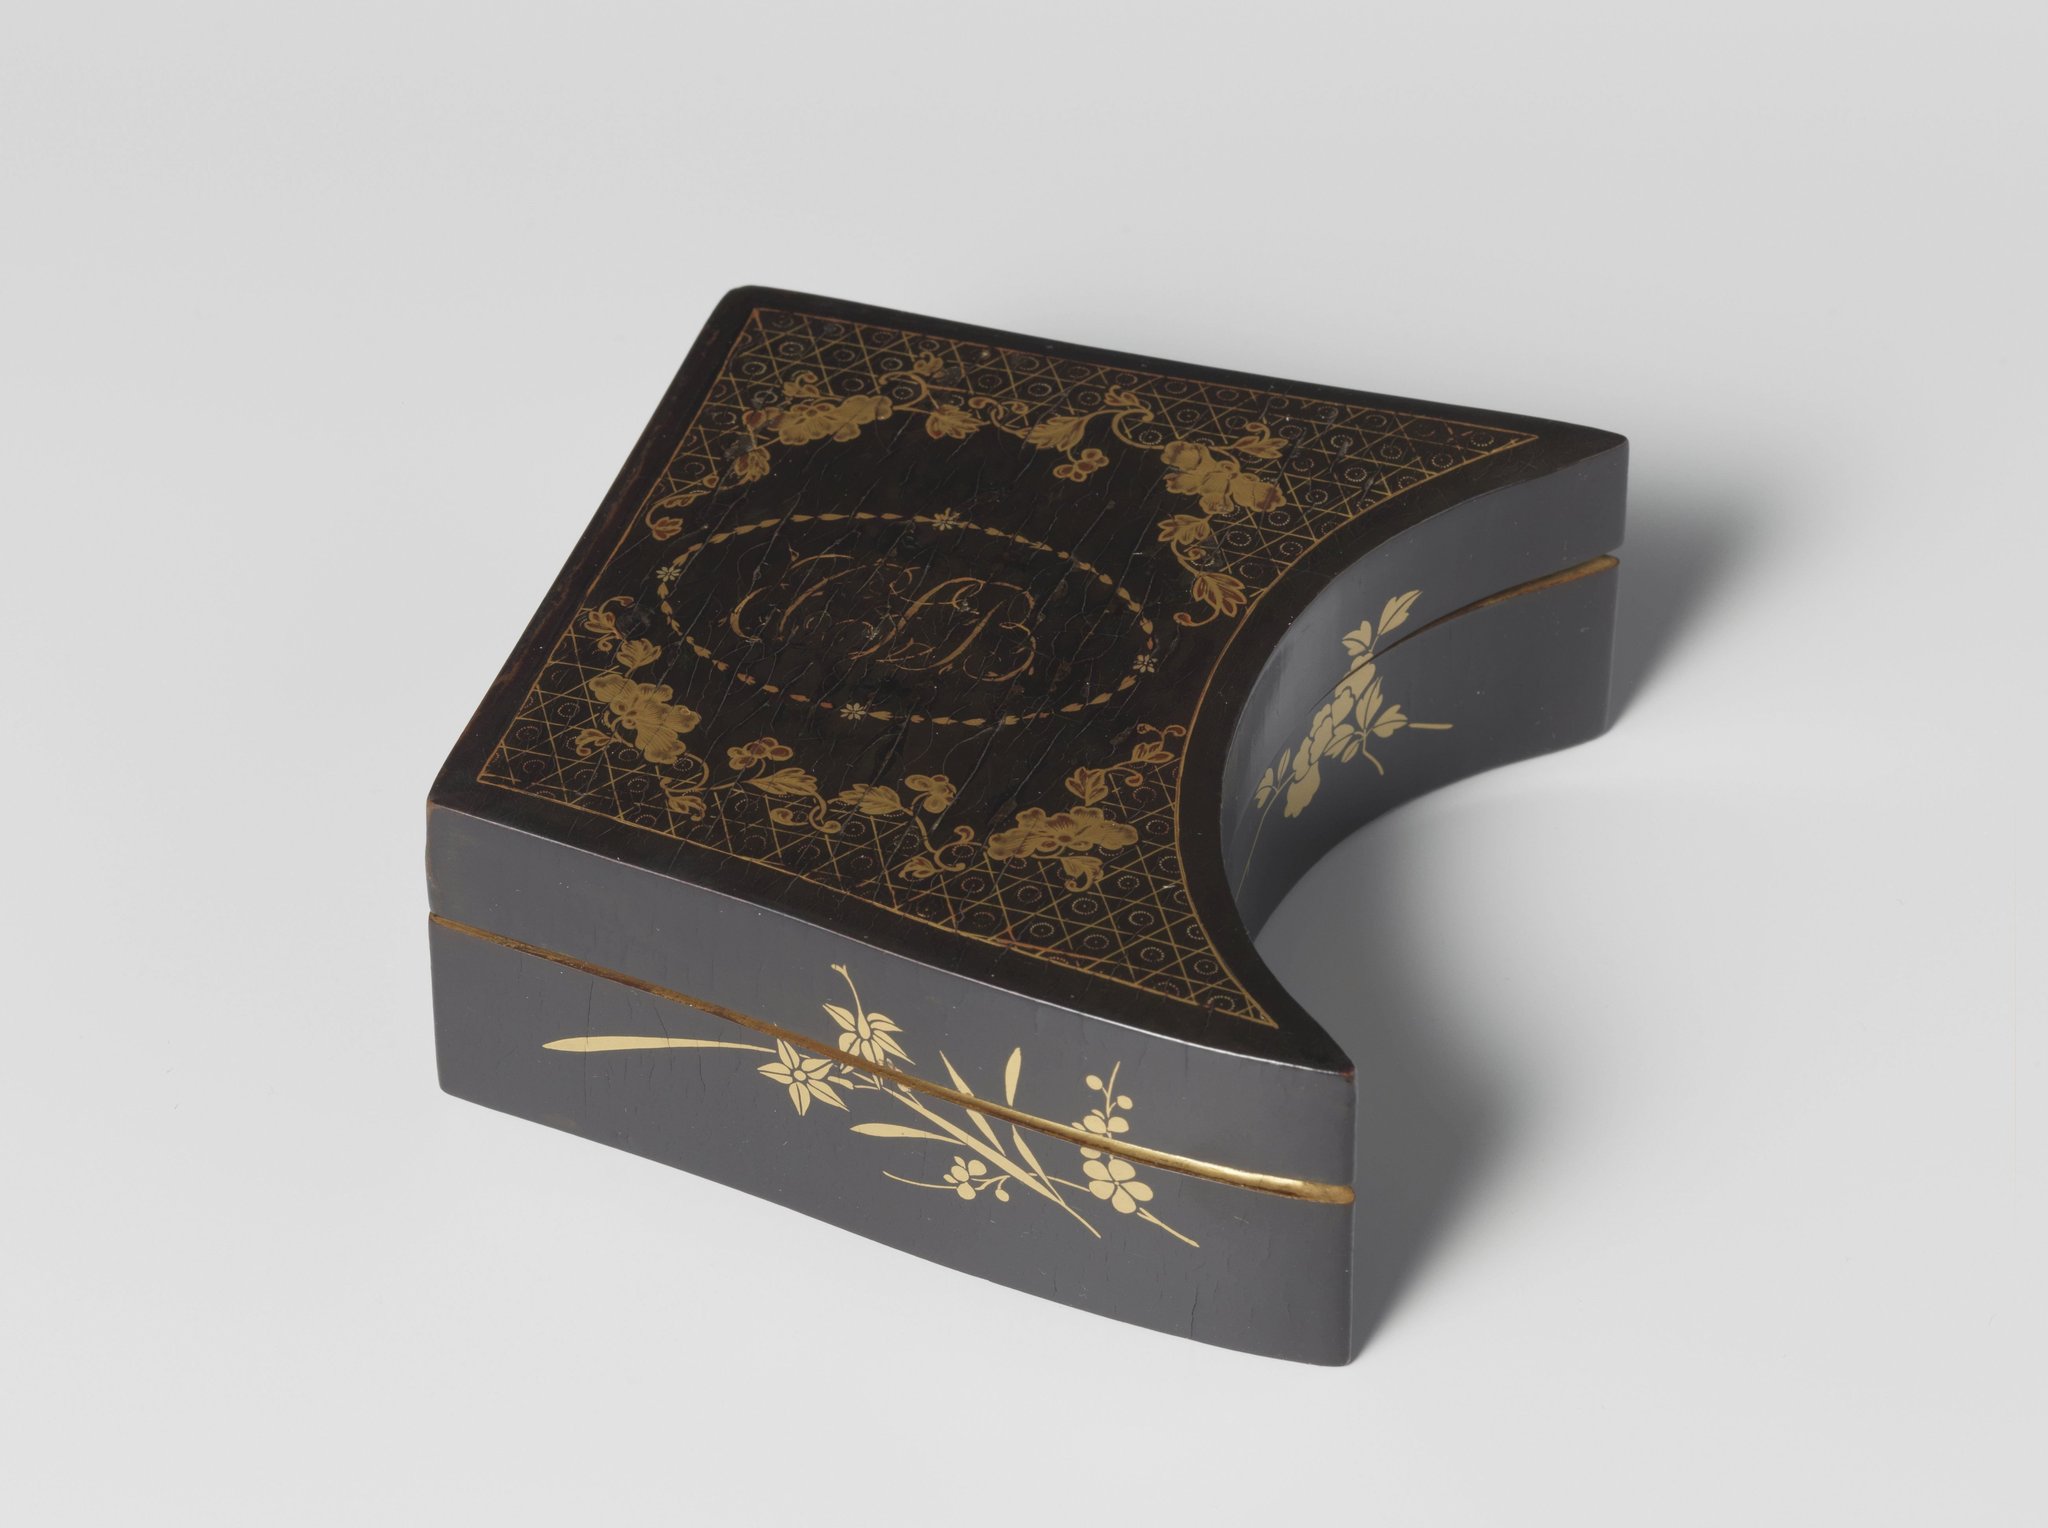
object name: dressing case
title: Box from Van Braam Houckgeest's toilet set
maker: Anonymous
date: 1795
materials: lacquer, glass, wood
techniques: lacquer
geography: guangdong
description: Doos behorend bij de spiegelstandaard AK-RAK-2003-8-1. Eén holle zijde en één enigszins bolle zijde. Bedekt met zwarte lak met gouden decoraties. Op de deksel een monogram ECVB omgeven door een smalle b and met bladmotieven en vier kleine bloemen. Rond het centrale medaillon een bloemband en buiten deze band is het oppervlak gevuld met geometrische motieven. Op de zijkanten losse bloemtakken.